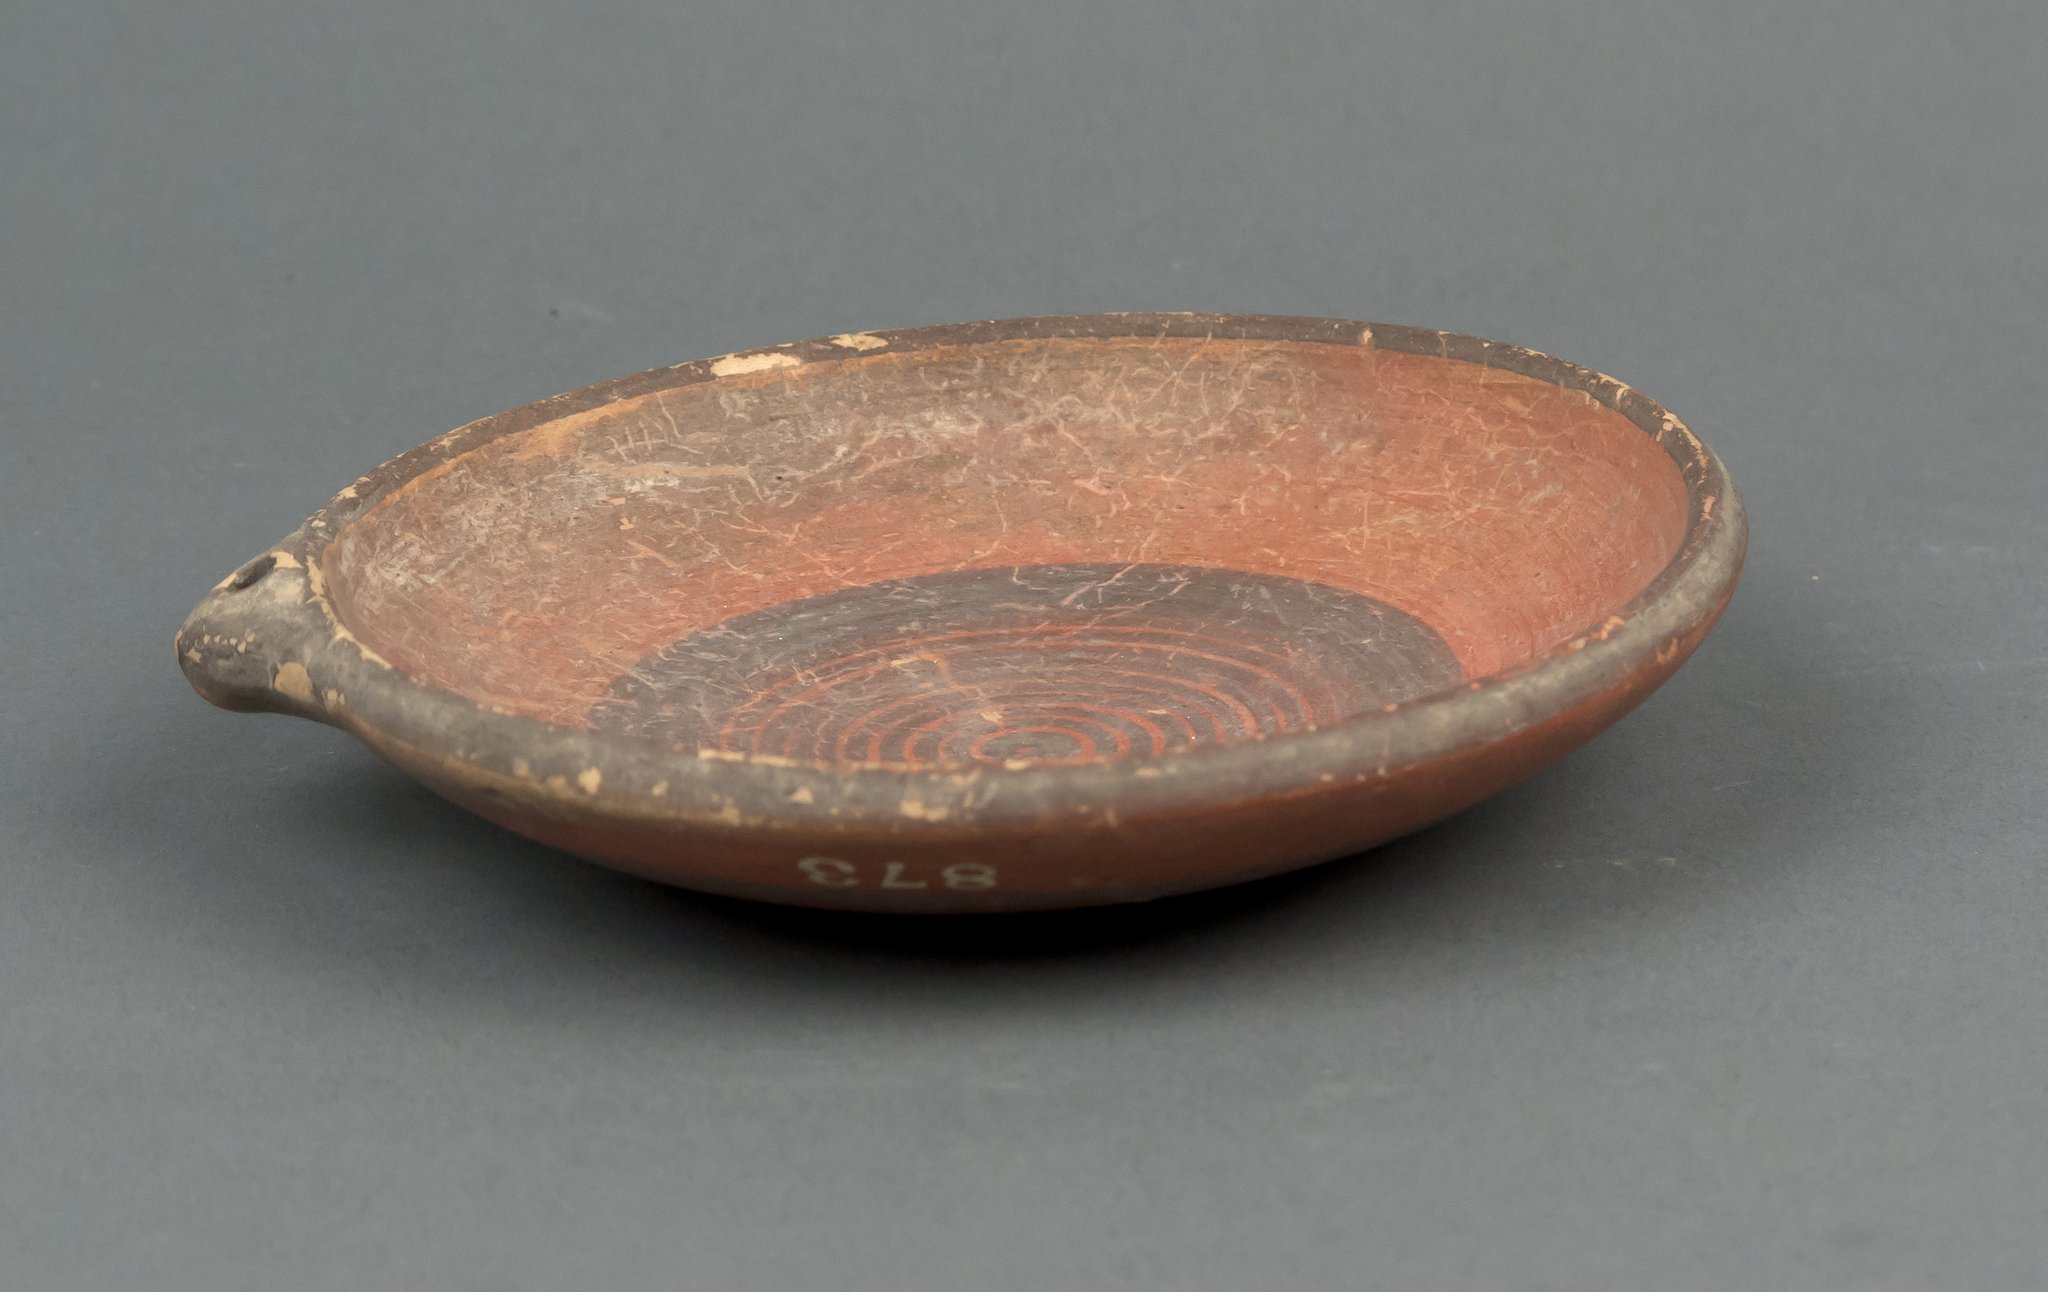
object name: bowl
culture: cypriot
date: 1125-1050 BCE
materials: terracotta